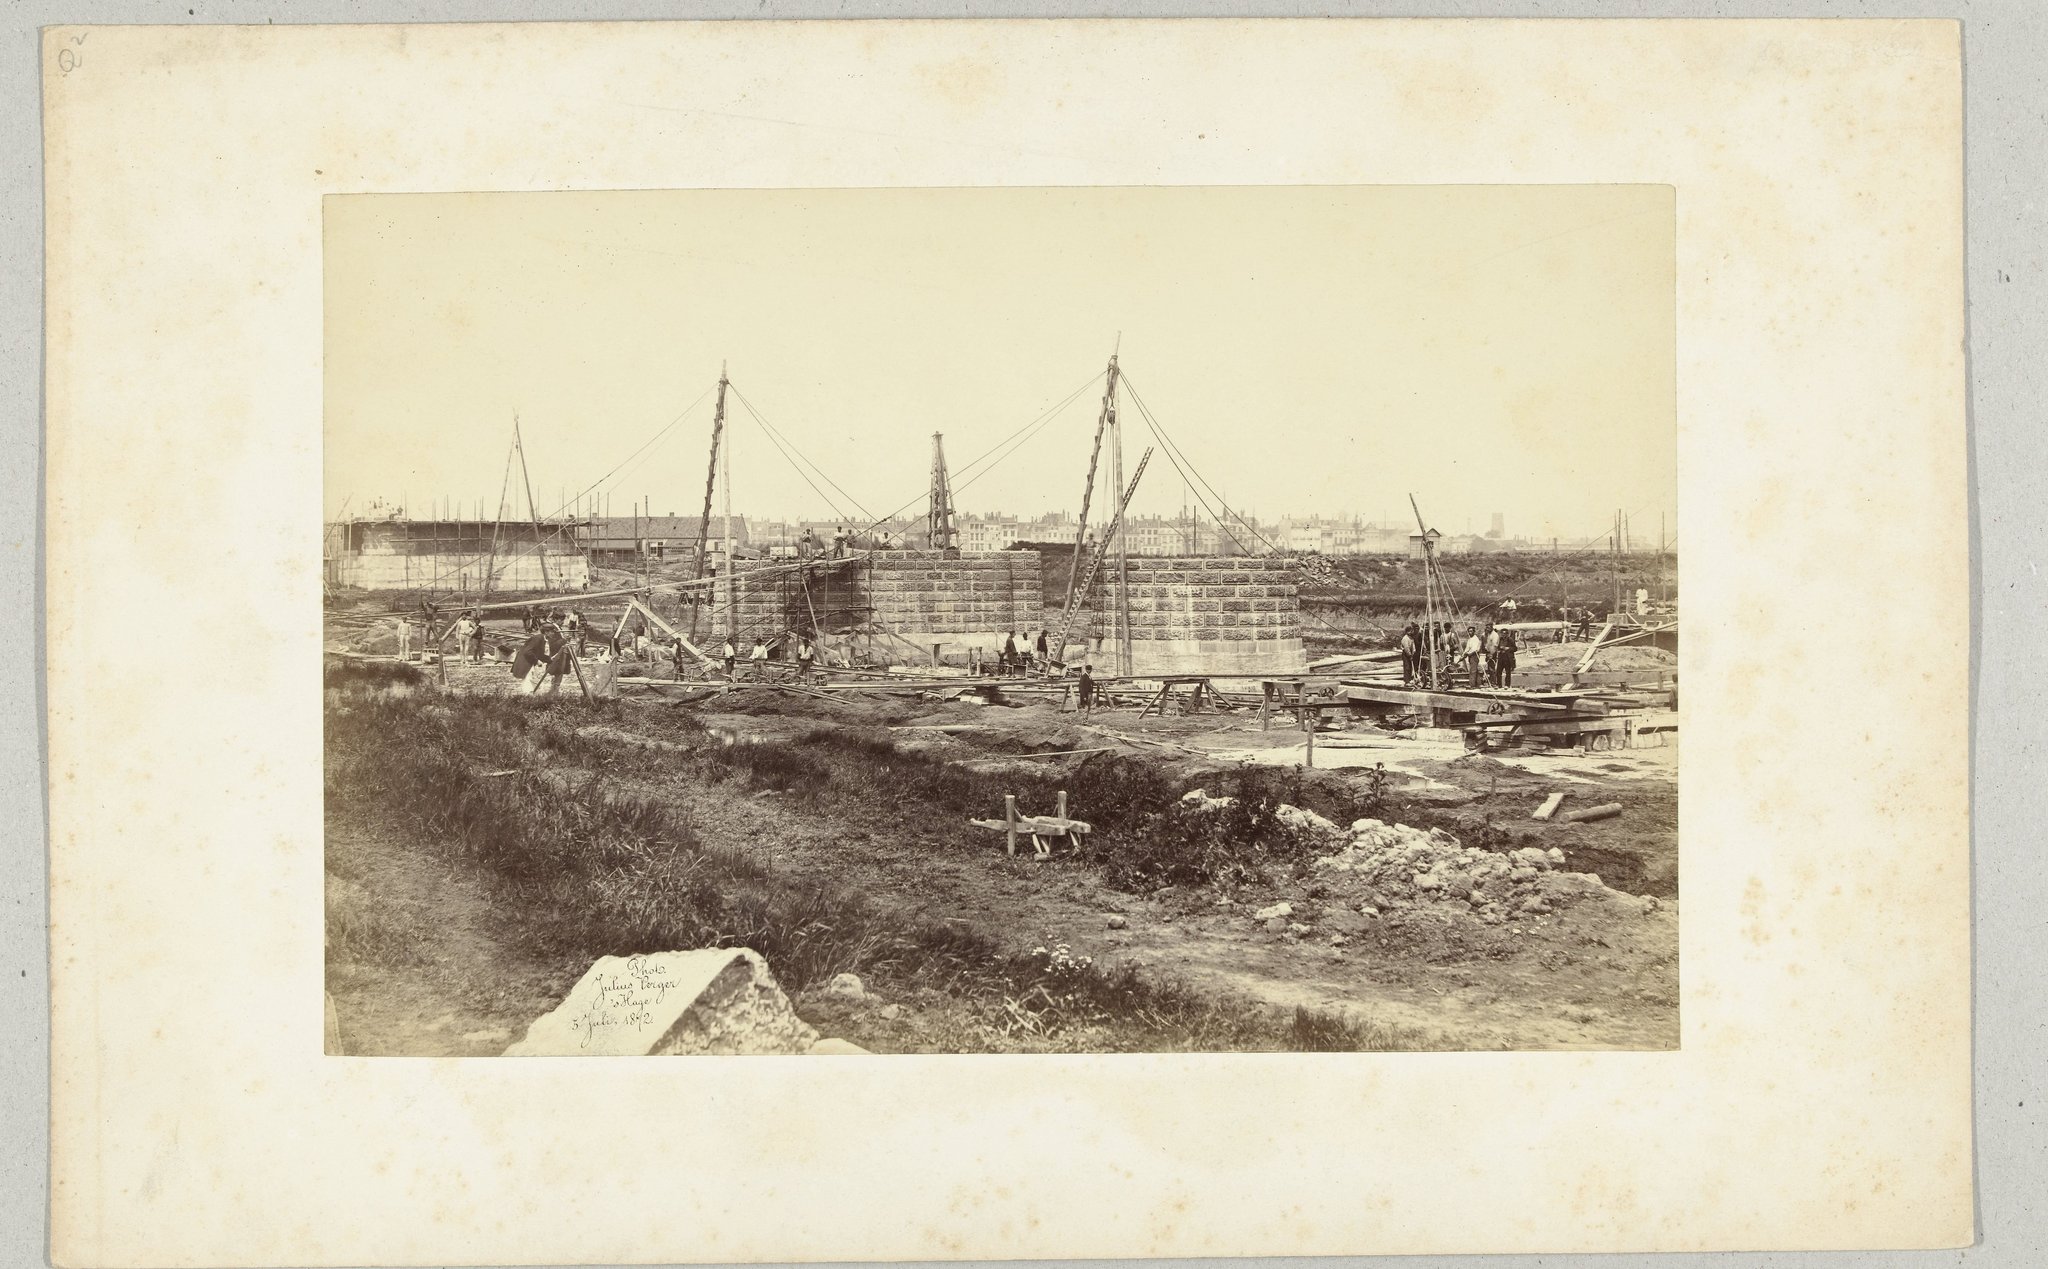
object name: photograph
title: Gezicht op de Noorderhaven in aanleg met de bouw van de spoorbrug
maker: julius perger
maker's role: fotograaf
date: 1872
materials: paper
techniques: albumen print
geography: the hague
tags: harbour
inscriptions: name: ‘Phot Julius Perger 's Hage 5 juli 1872’